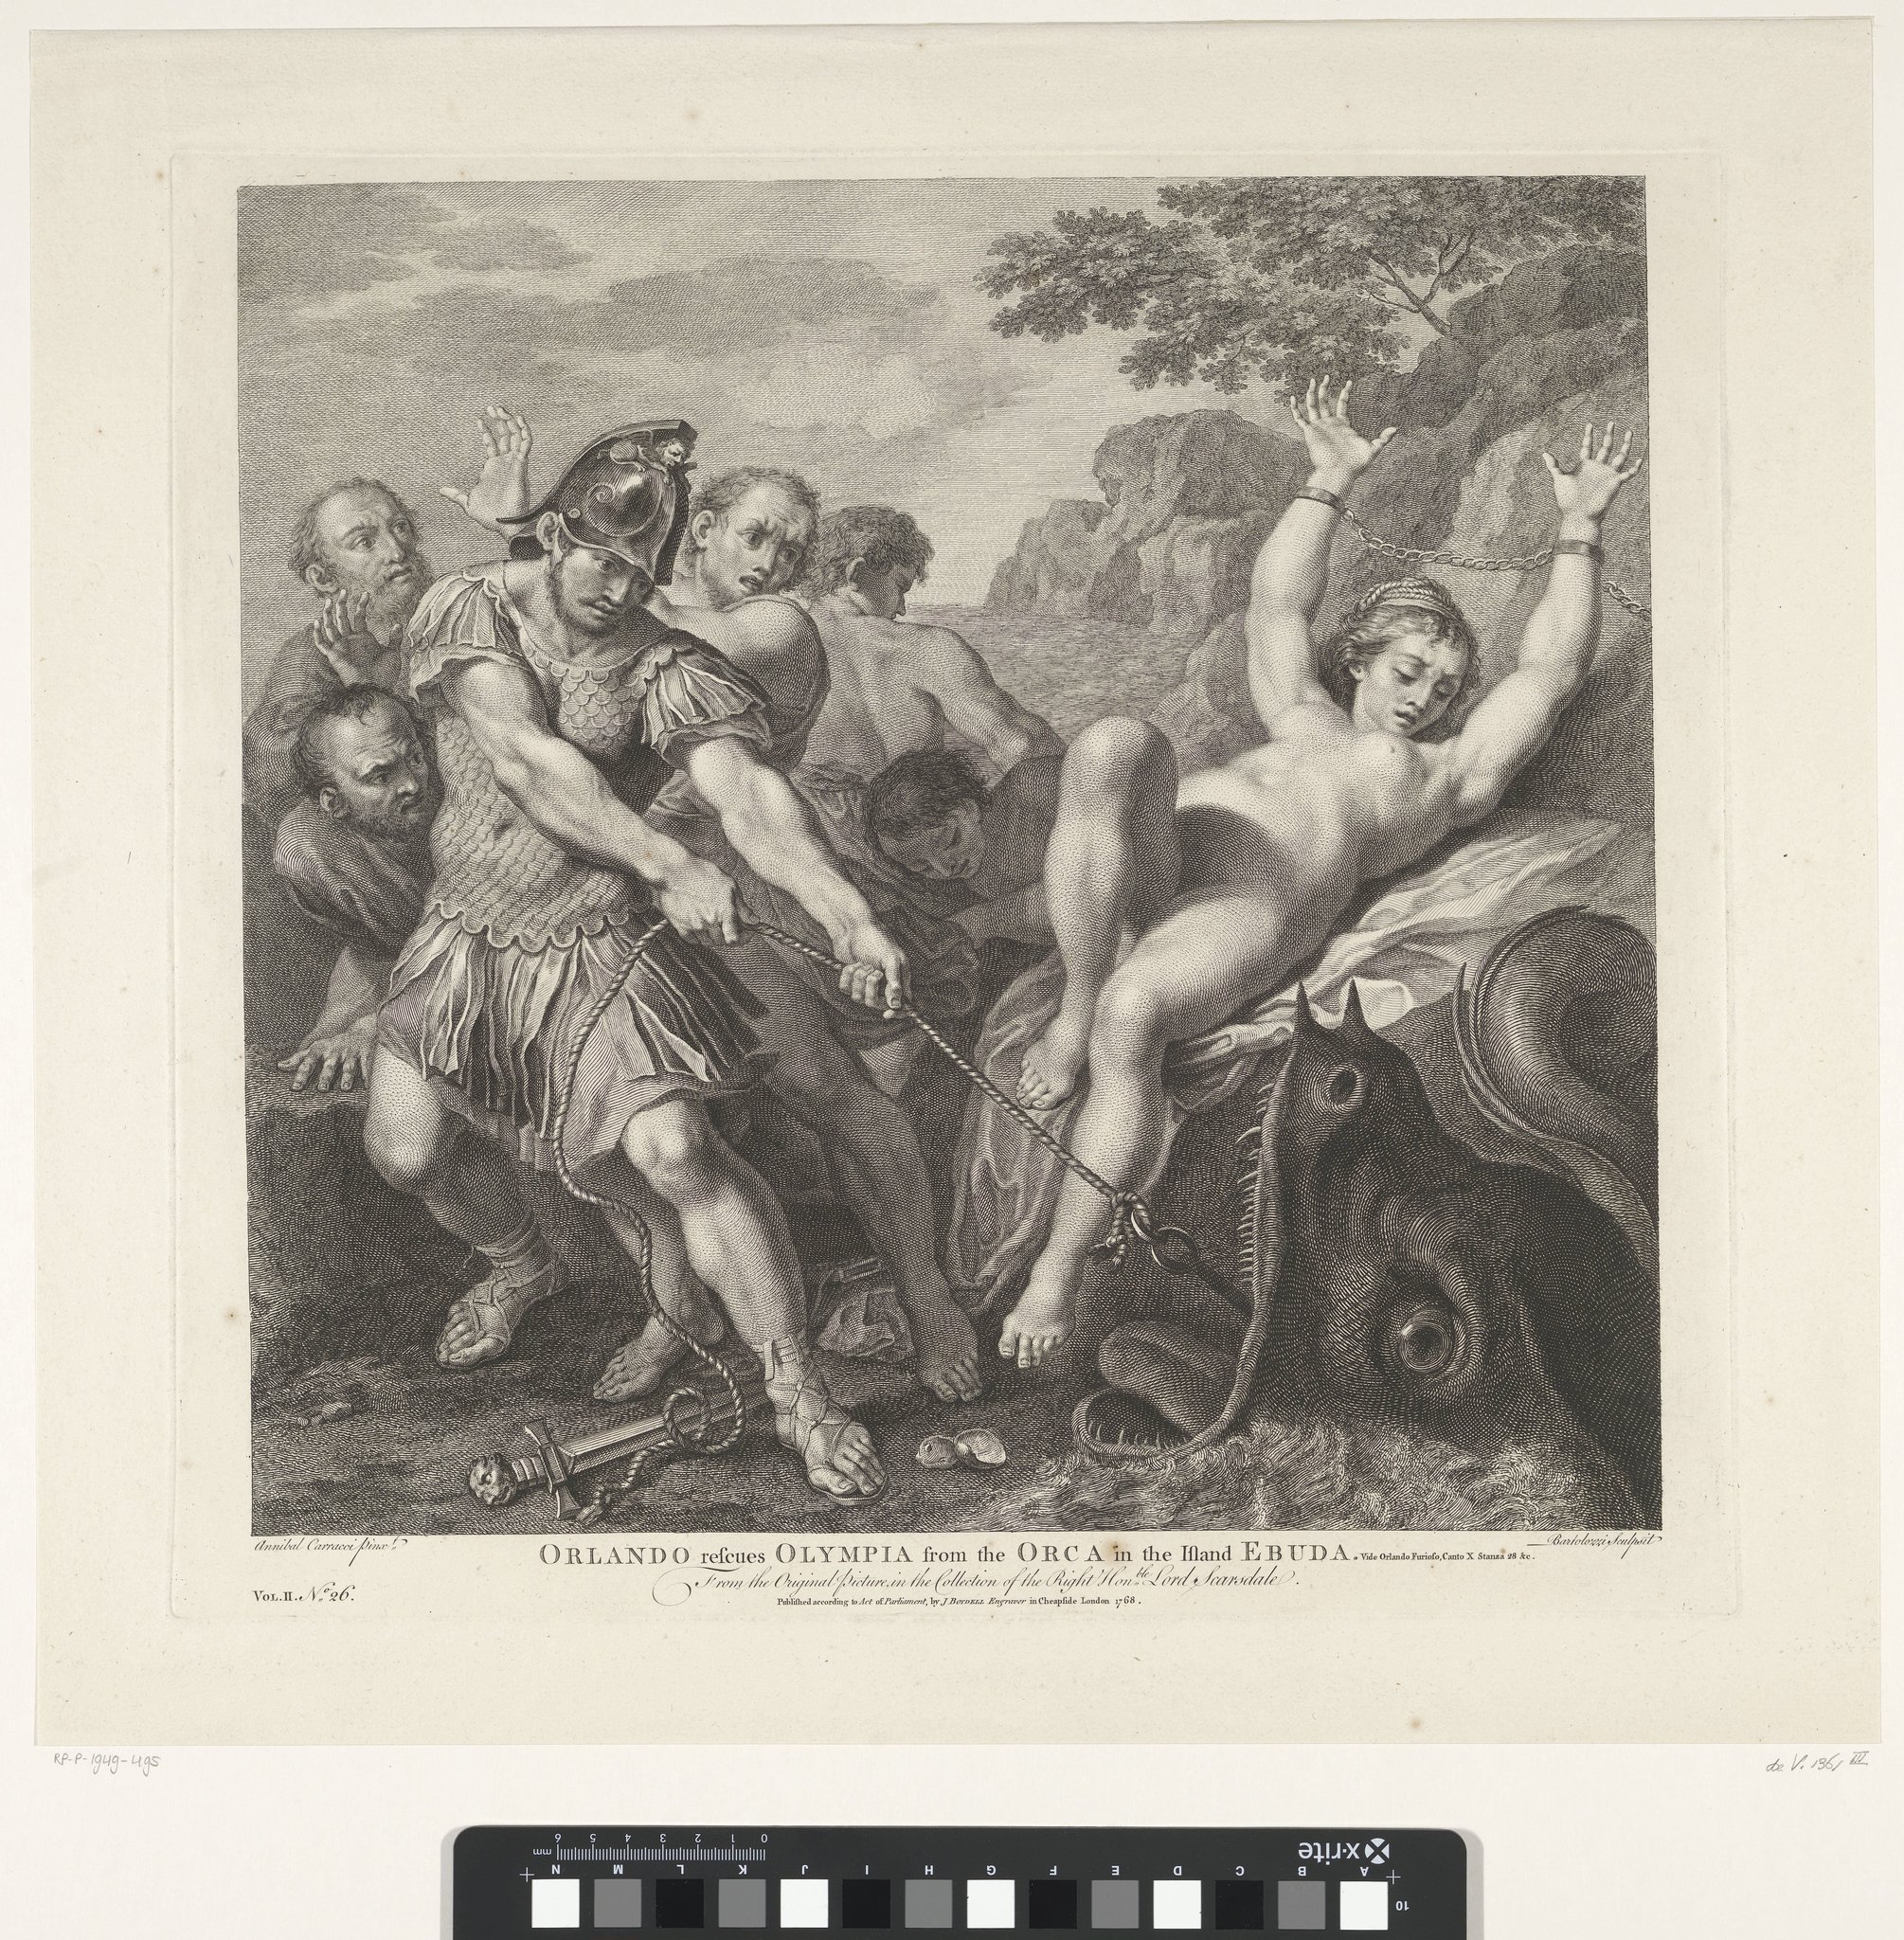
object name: print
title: Orlando redt Olympia van de Orca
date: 1738-1815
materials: paper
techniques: engraving, etching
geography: london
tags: (scenes from) specific works of literature: ariosto, orlando furioso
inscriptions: collector's mark: Lugt 2228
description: Orlando redt de vastgeketende Olympia van een zeemonster (Orca), door deze te vangen met een haak en een touw. Een groep mannen achter Orlando kijkt toe. Genummerd linksonder: Vol. II. No. 26.